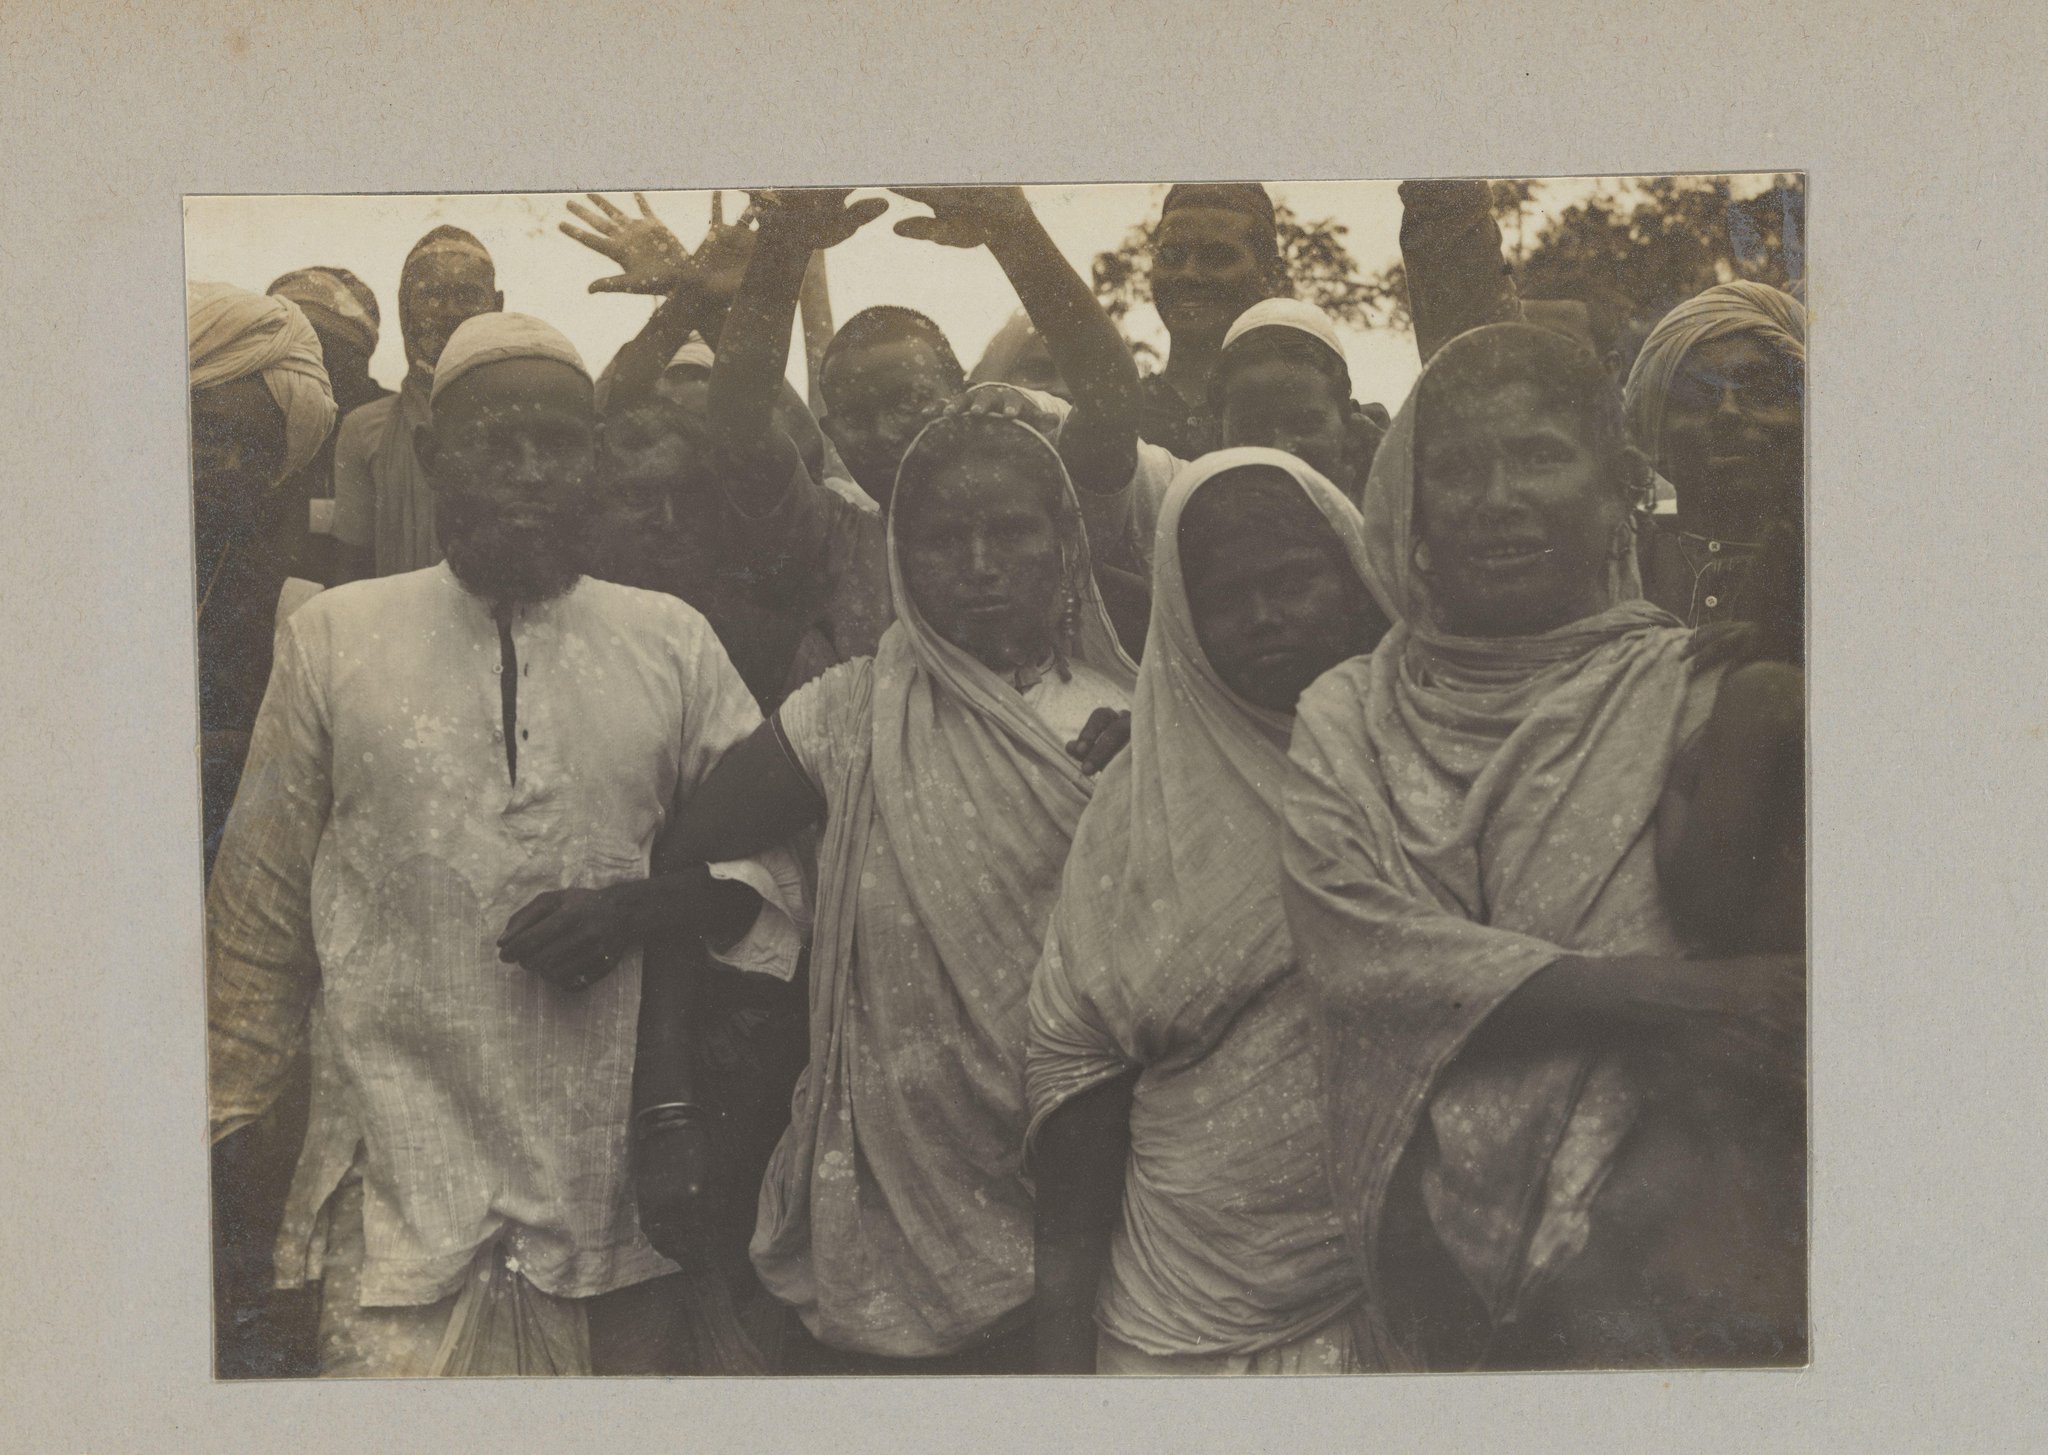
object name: photograph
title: In het koeliedepôt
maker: hendrik doijer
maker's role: engineer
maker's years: 1863-1925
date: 1903-1910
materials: photographic support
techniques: gelatin silver print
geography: suriname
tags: working class, labourers, suriname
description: Contractarbeiders uit Brits-Indië in het zgn. ‘koeliedepot’, het centrale verzamelpunt voor immigranten in Paramaribo. Onderdeel van het fotoalbum Souvenir de Voyage (deel 5), over het leven van de familie Doijer in en rond de plantage Ma Retraite in Suriname in de jaren 1903-1910.